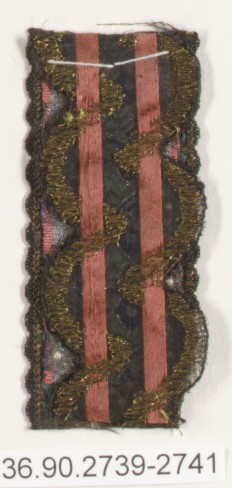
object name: ribbon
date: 1801-1900